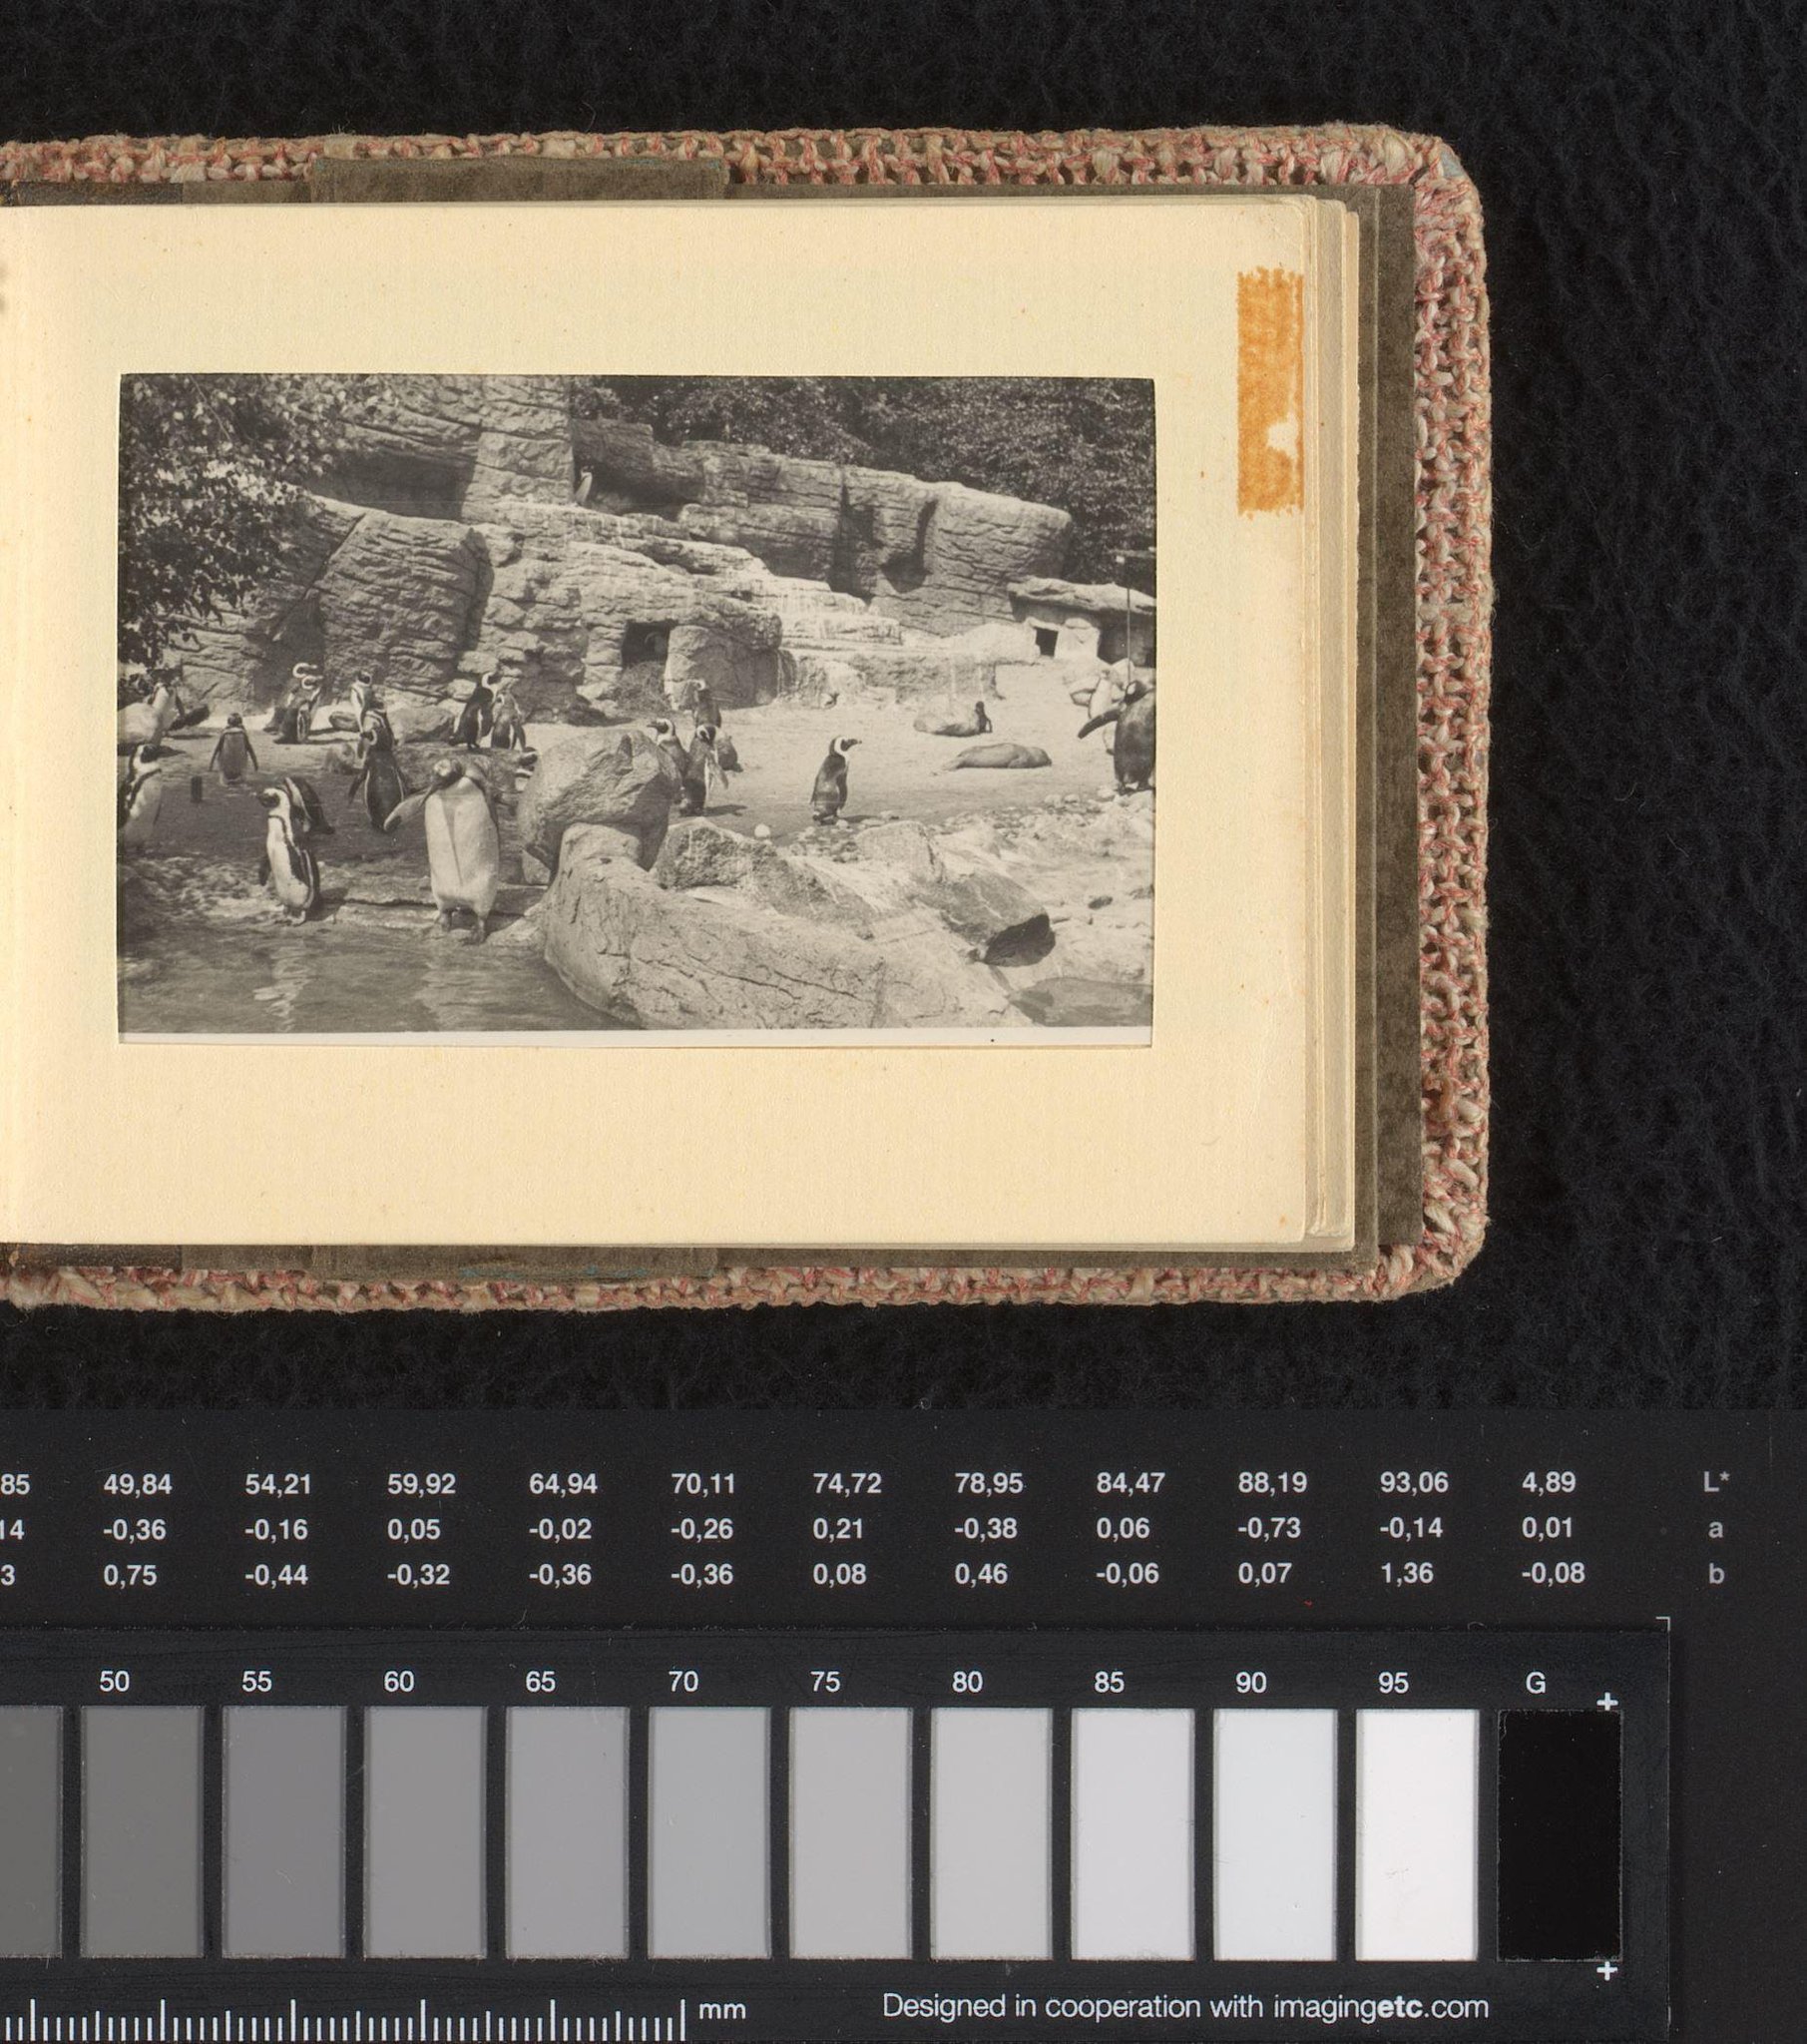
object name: photograph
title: Pinguïns in de dierentuin, juni-augustus 1933, Hamburg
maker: else wachenheimer-moos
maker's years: 1895-1944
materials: paper, photographic support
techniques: gelatin silver print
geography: hamburg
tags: the family travelling, on holiday, water-birds: penguin, zoo (as place of recreation)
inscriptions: date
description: Albumblad bevat een foto. Onderdeel van het fotoalbum Hamburg zomer 1933.